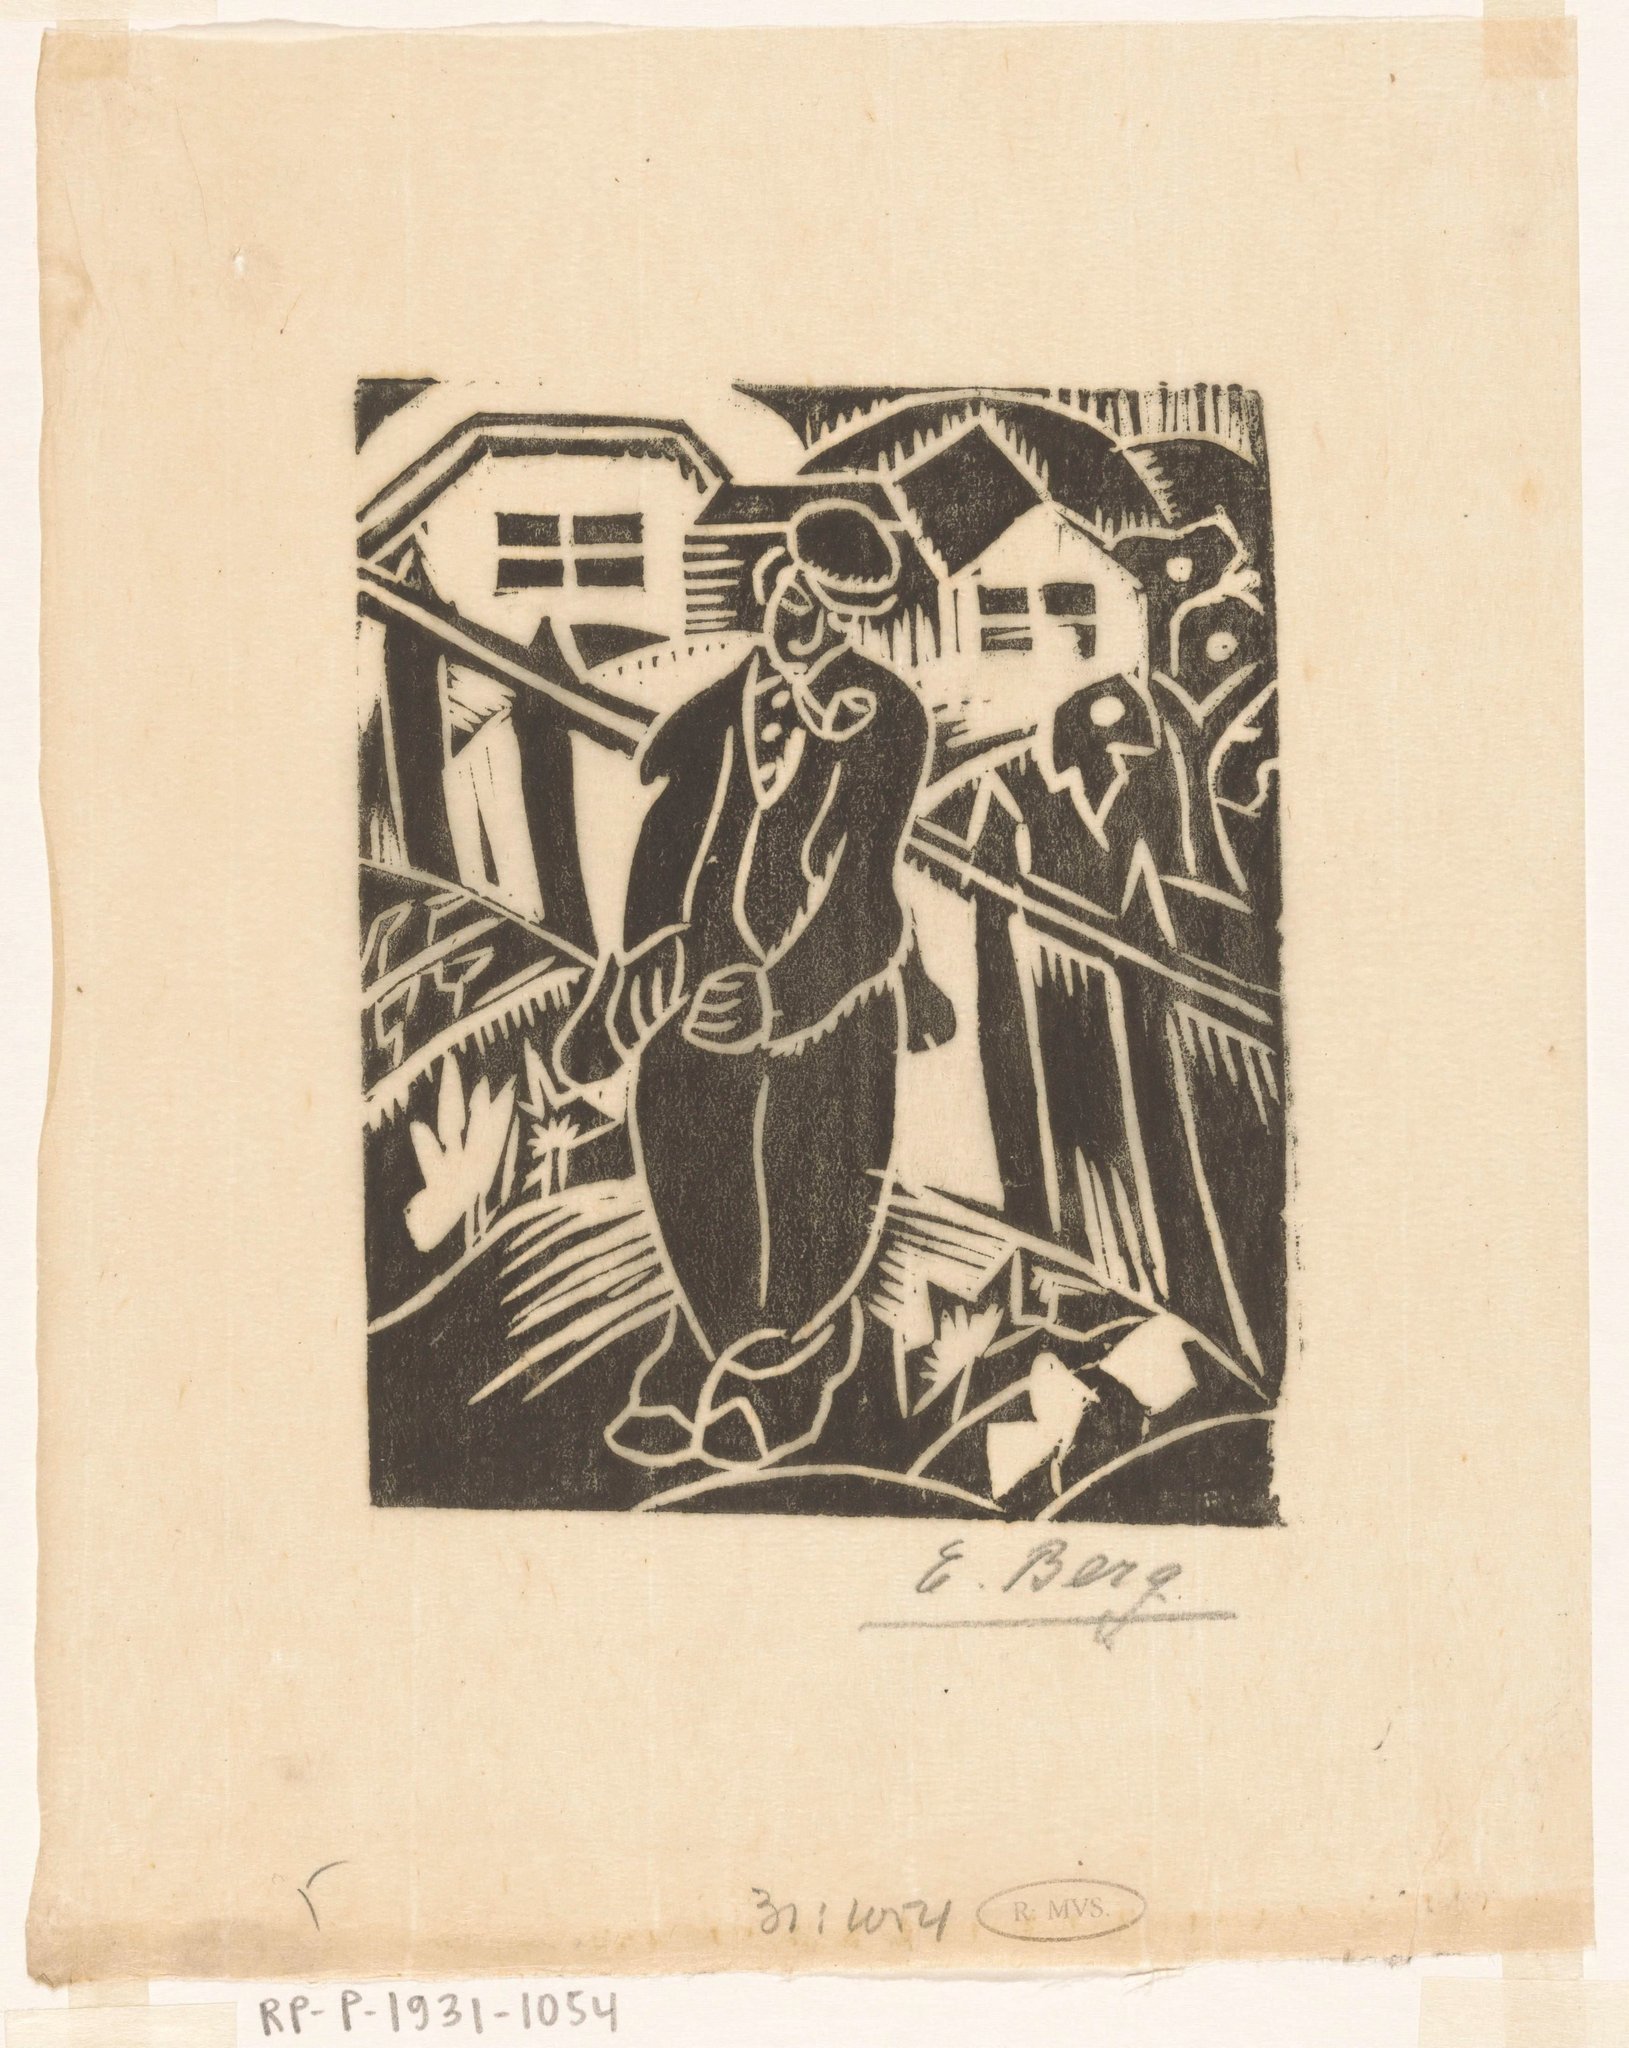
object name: print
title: Man in moestuin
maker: else berg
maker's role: designer, draughtsman, painter, print maker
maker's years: 1877-1942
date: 1912-1931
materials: paper, ink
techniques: woodcut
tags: gardening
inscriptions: signature: ‘E. Berg’, collector's mark: Lugt 2228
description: Man met een pet op en een pijp in zijn mond, staand in een moestuin met op de achtergrond huizen; gestileerd weergegeven.